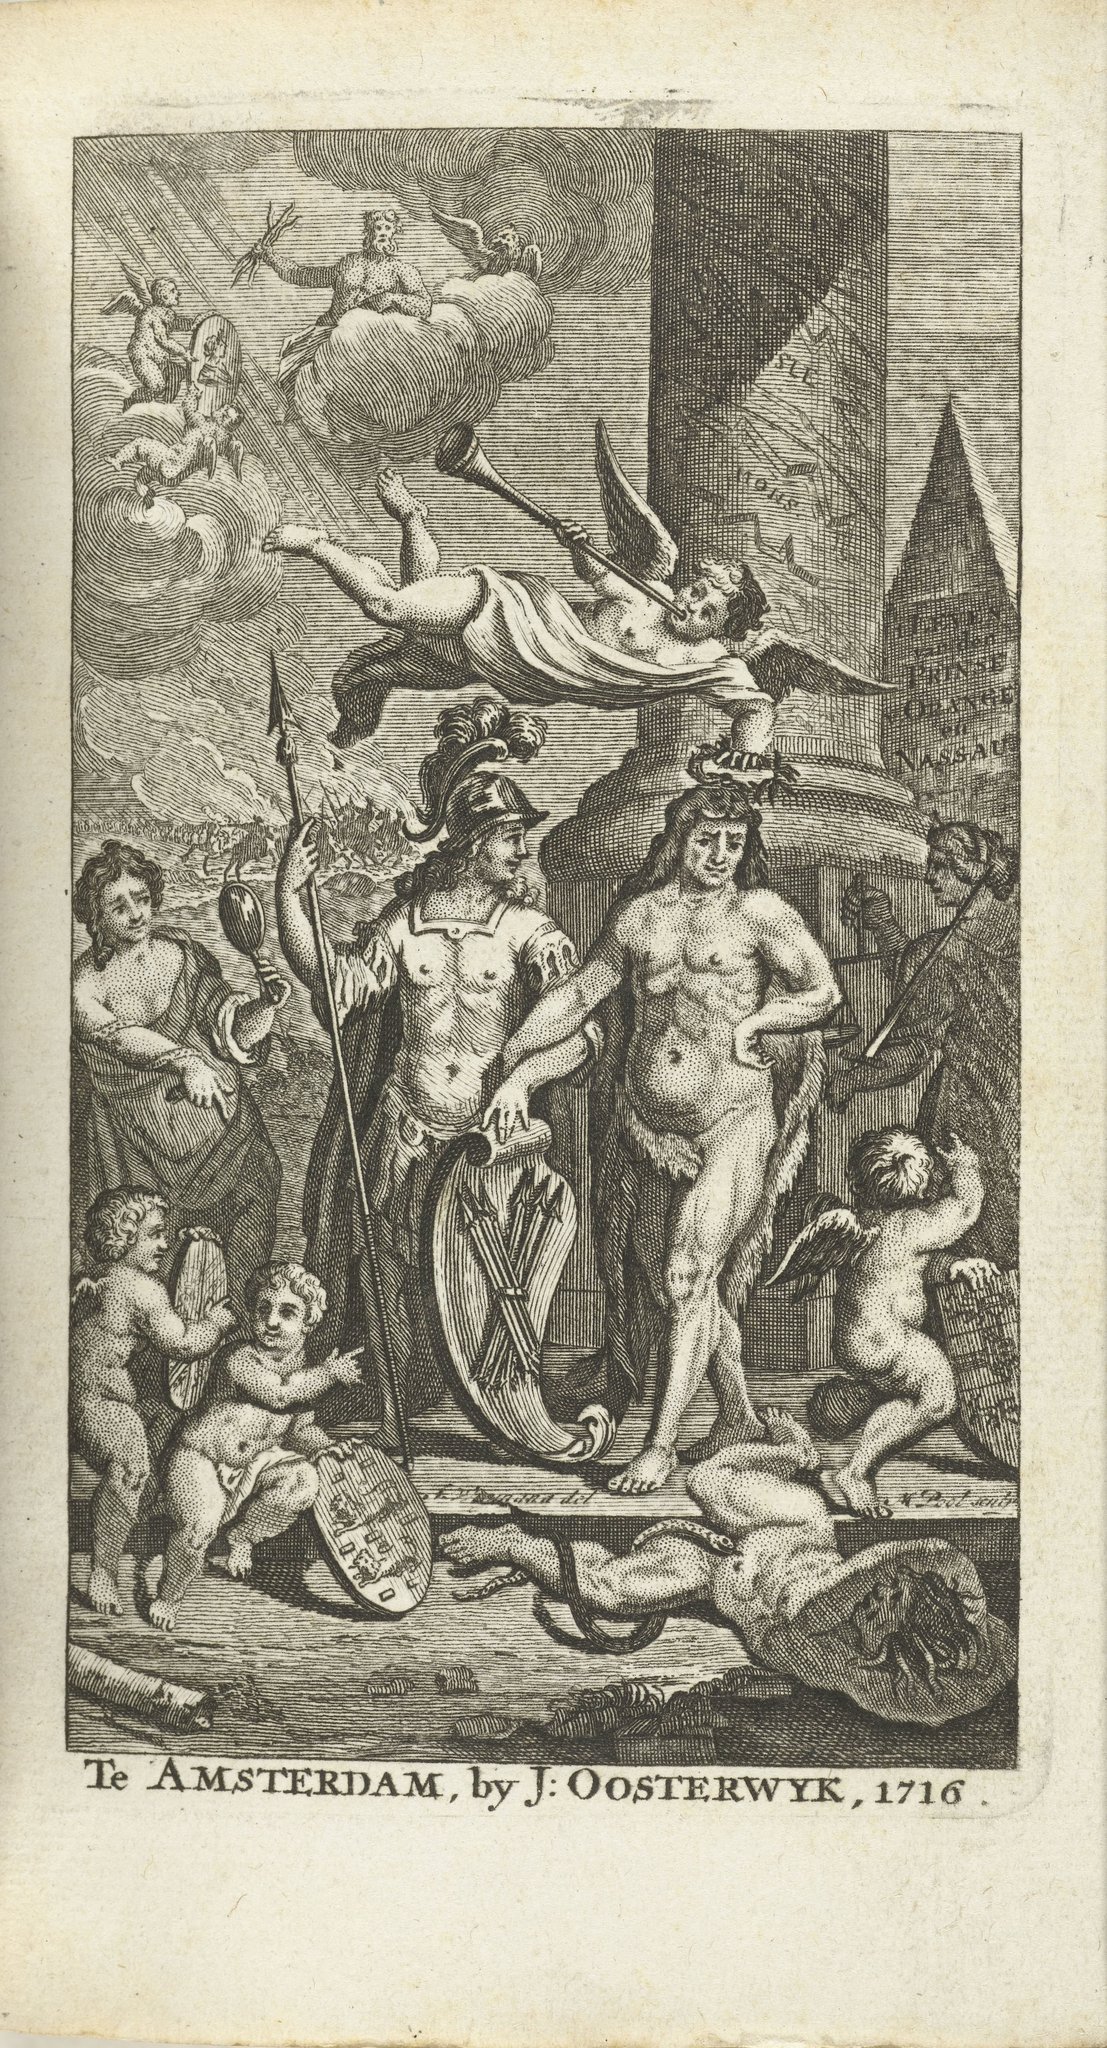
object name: titelblad, titelpagina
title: Gegraveerde titelpagina voor J. Lamigue: Het leven van Zyne Hoogheit Johan Willem Friso, 1716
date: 1716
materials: paper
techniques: etching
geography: northern netherlands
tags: johan willem friso (prins van oranje-nassau), justice, 'justitia'; 'giustitia divina' (ripa) ~ one of the four cardinal virtues, fame; 'fama', 'fama buona', 'fama chiara' (ripa), specific aspects, allegorical aspects of hercules; hercules as patron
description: Gegraveerde titelpagina met een allegorische voorstelling van Hercules gelauwerd door de Faam, met Minerva, Voorzichtigheid en Rechtvaardigheid. Op de achtergrond een zuil, obelisk en een oorlogstafereel. Illustratie in de Nederlandse vertaling uit 1716 van J. Lamigue, Het leven van Zyne Hoogheit Johan Willem Friso.